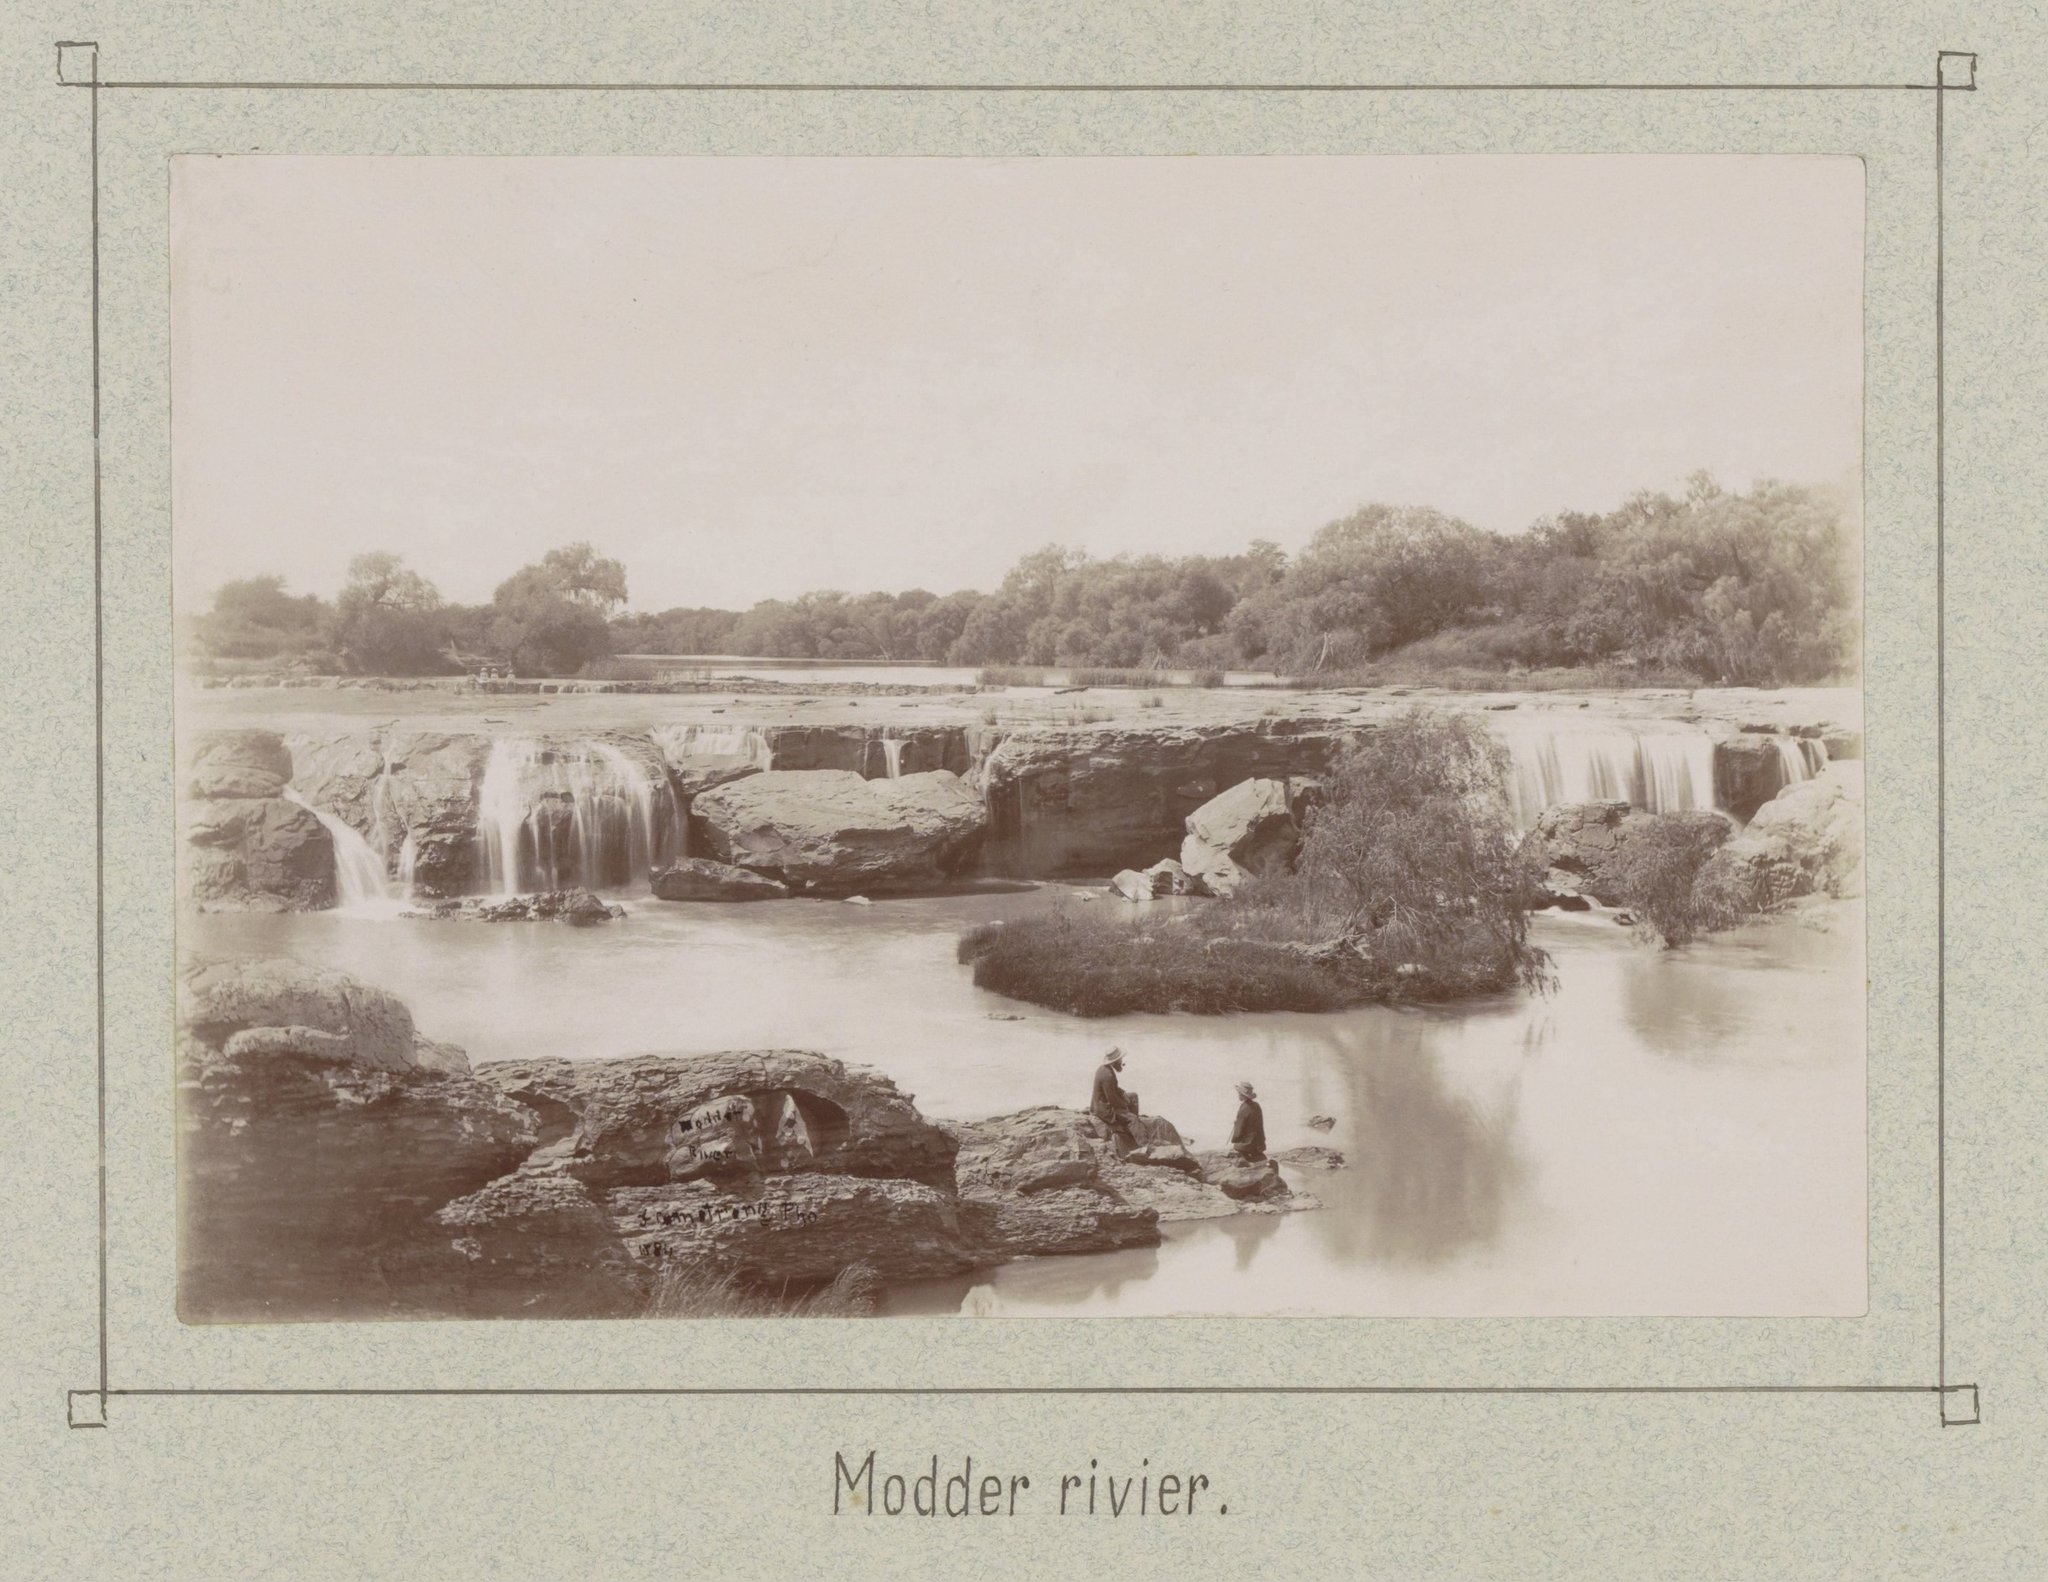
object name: photograph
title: Gezicht op de Modderrivier in Zuid-Afrika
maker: Anonymous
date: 1884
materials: photographic support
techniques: albumen print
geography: south africa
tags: river (+ landscape with figures, staffage)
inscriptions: inscription: ‘Modder Rivier [...]Pho 1884’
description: Onderdeel van Reisalbum met foto's van Zuid-Afrika, Madeira, Portugal, Frankrijk en Duitsland.